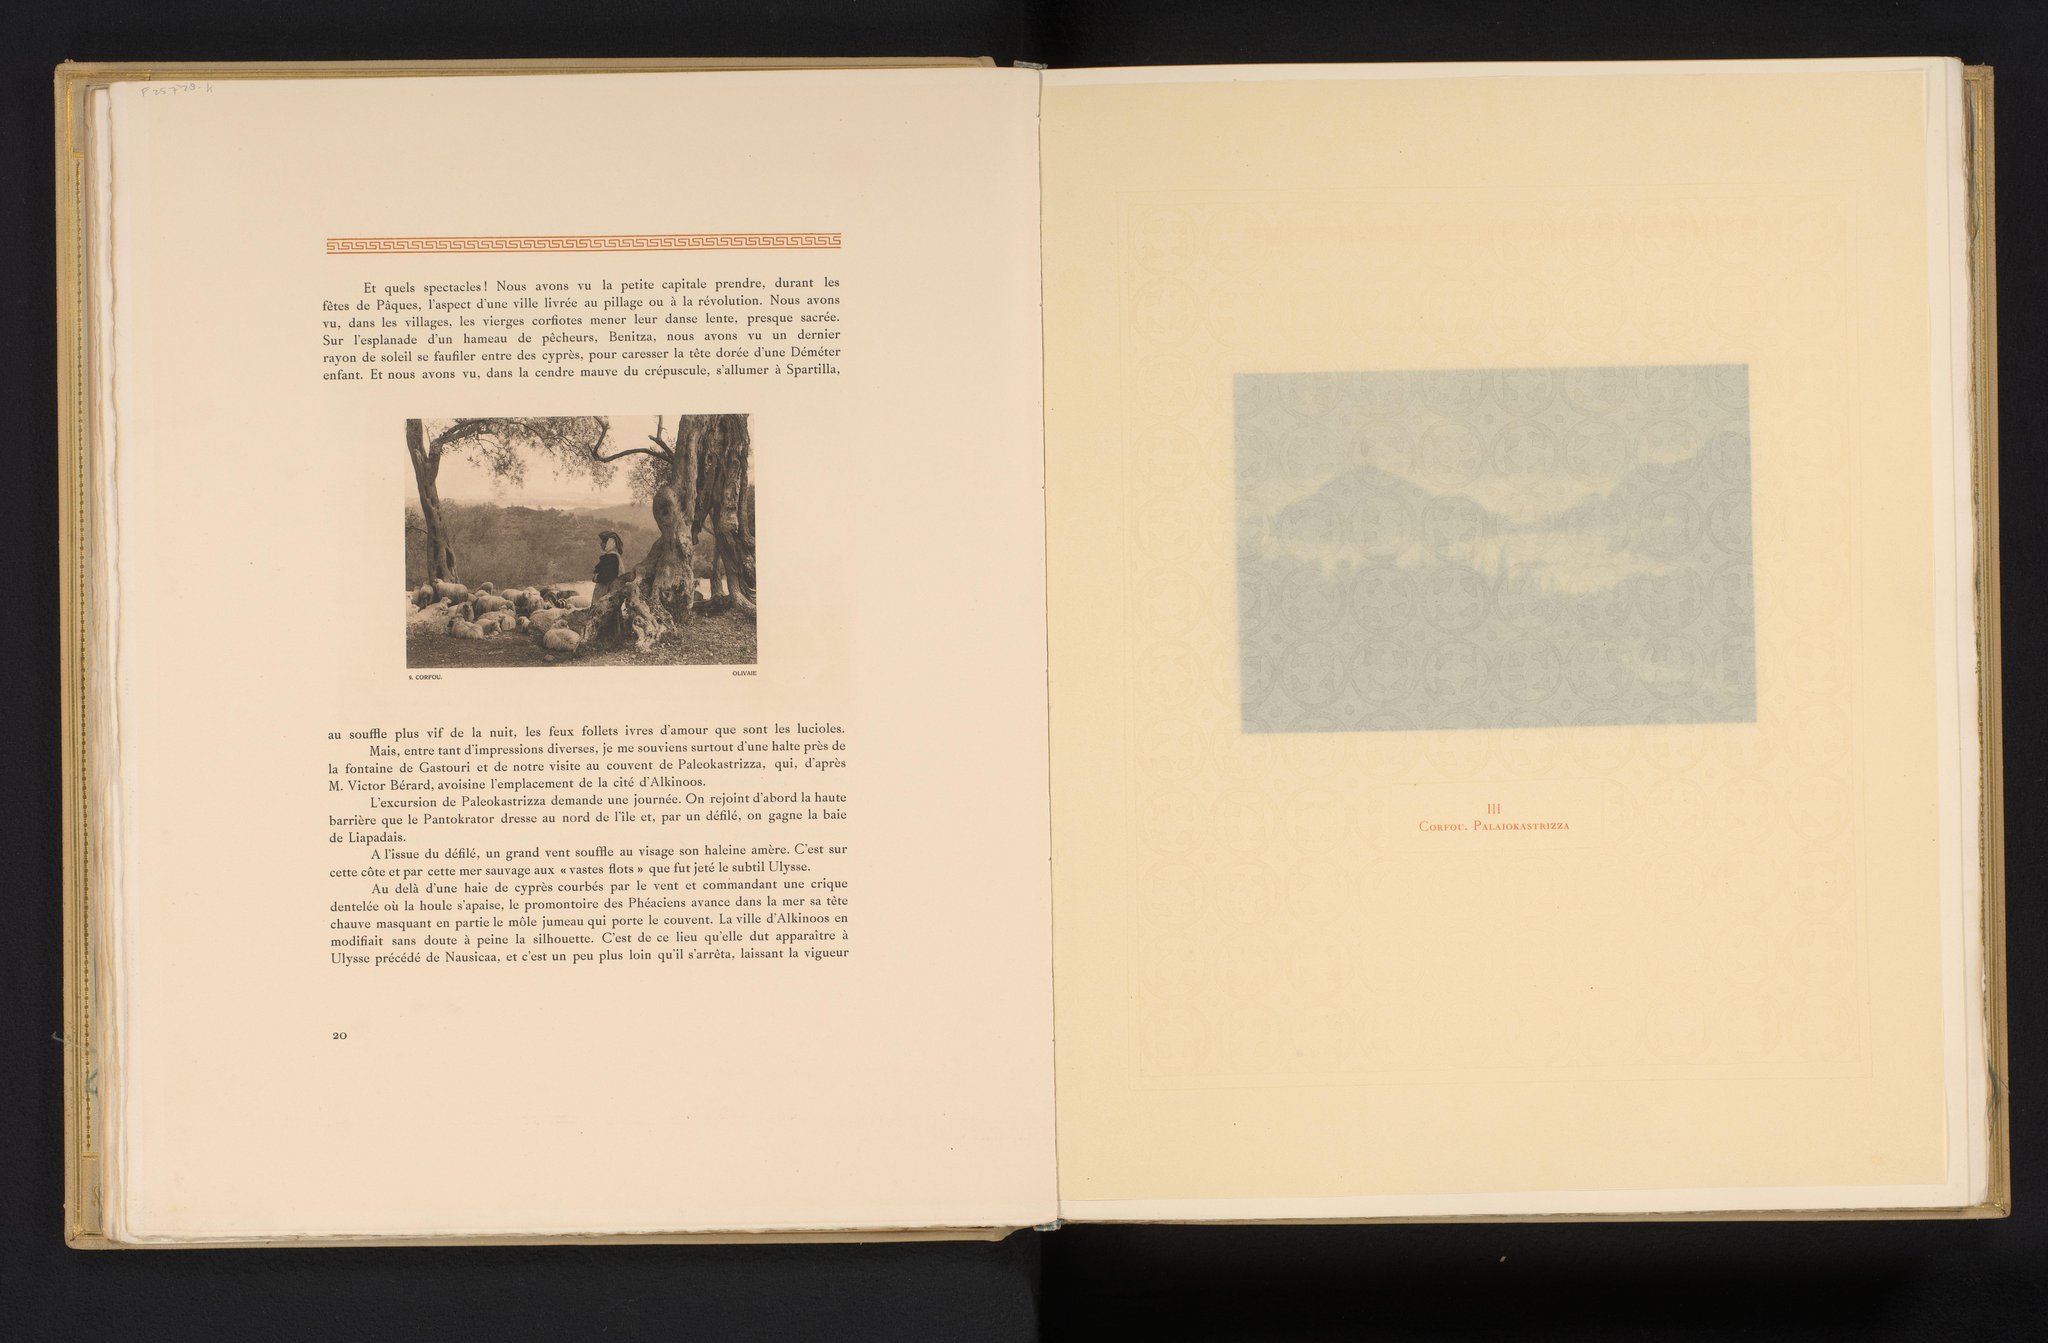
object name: photomechanical print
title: Herderin met schapen in een olijfgaard op Korfoe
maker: frédéric boissonnas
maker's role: fotograaf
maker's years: 1858-1946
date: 1905-1910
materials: paper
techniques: photograph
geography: berlin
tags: herding, herdsman, herdswoman, shepherd, shepherdess, cowherd, etc., sheep, trees: olive-tree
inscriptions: number: ‘9.’